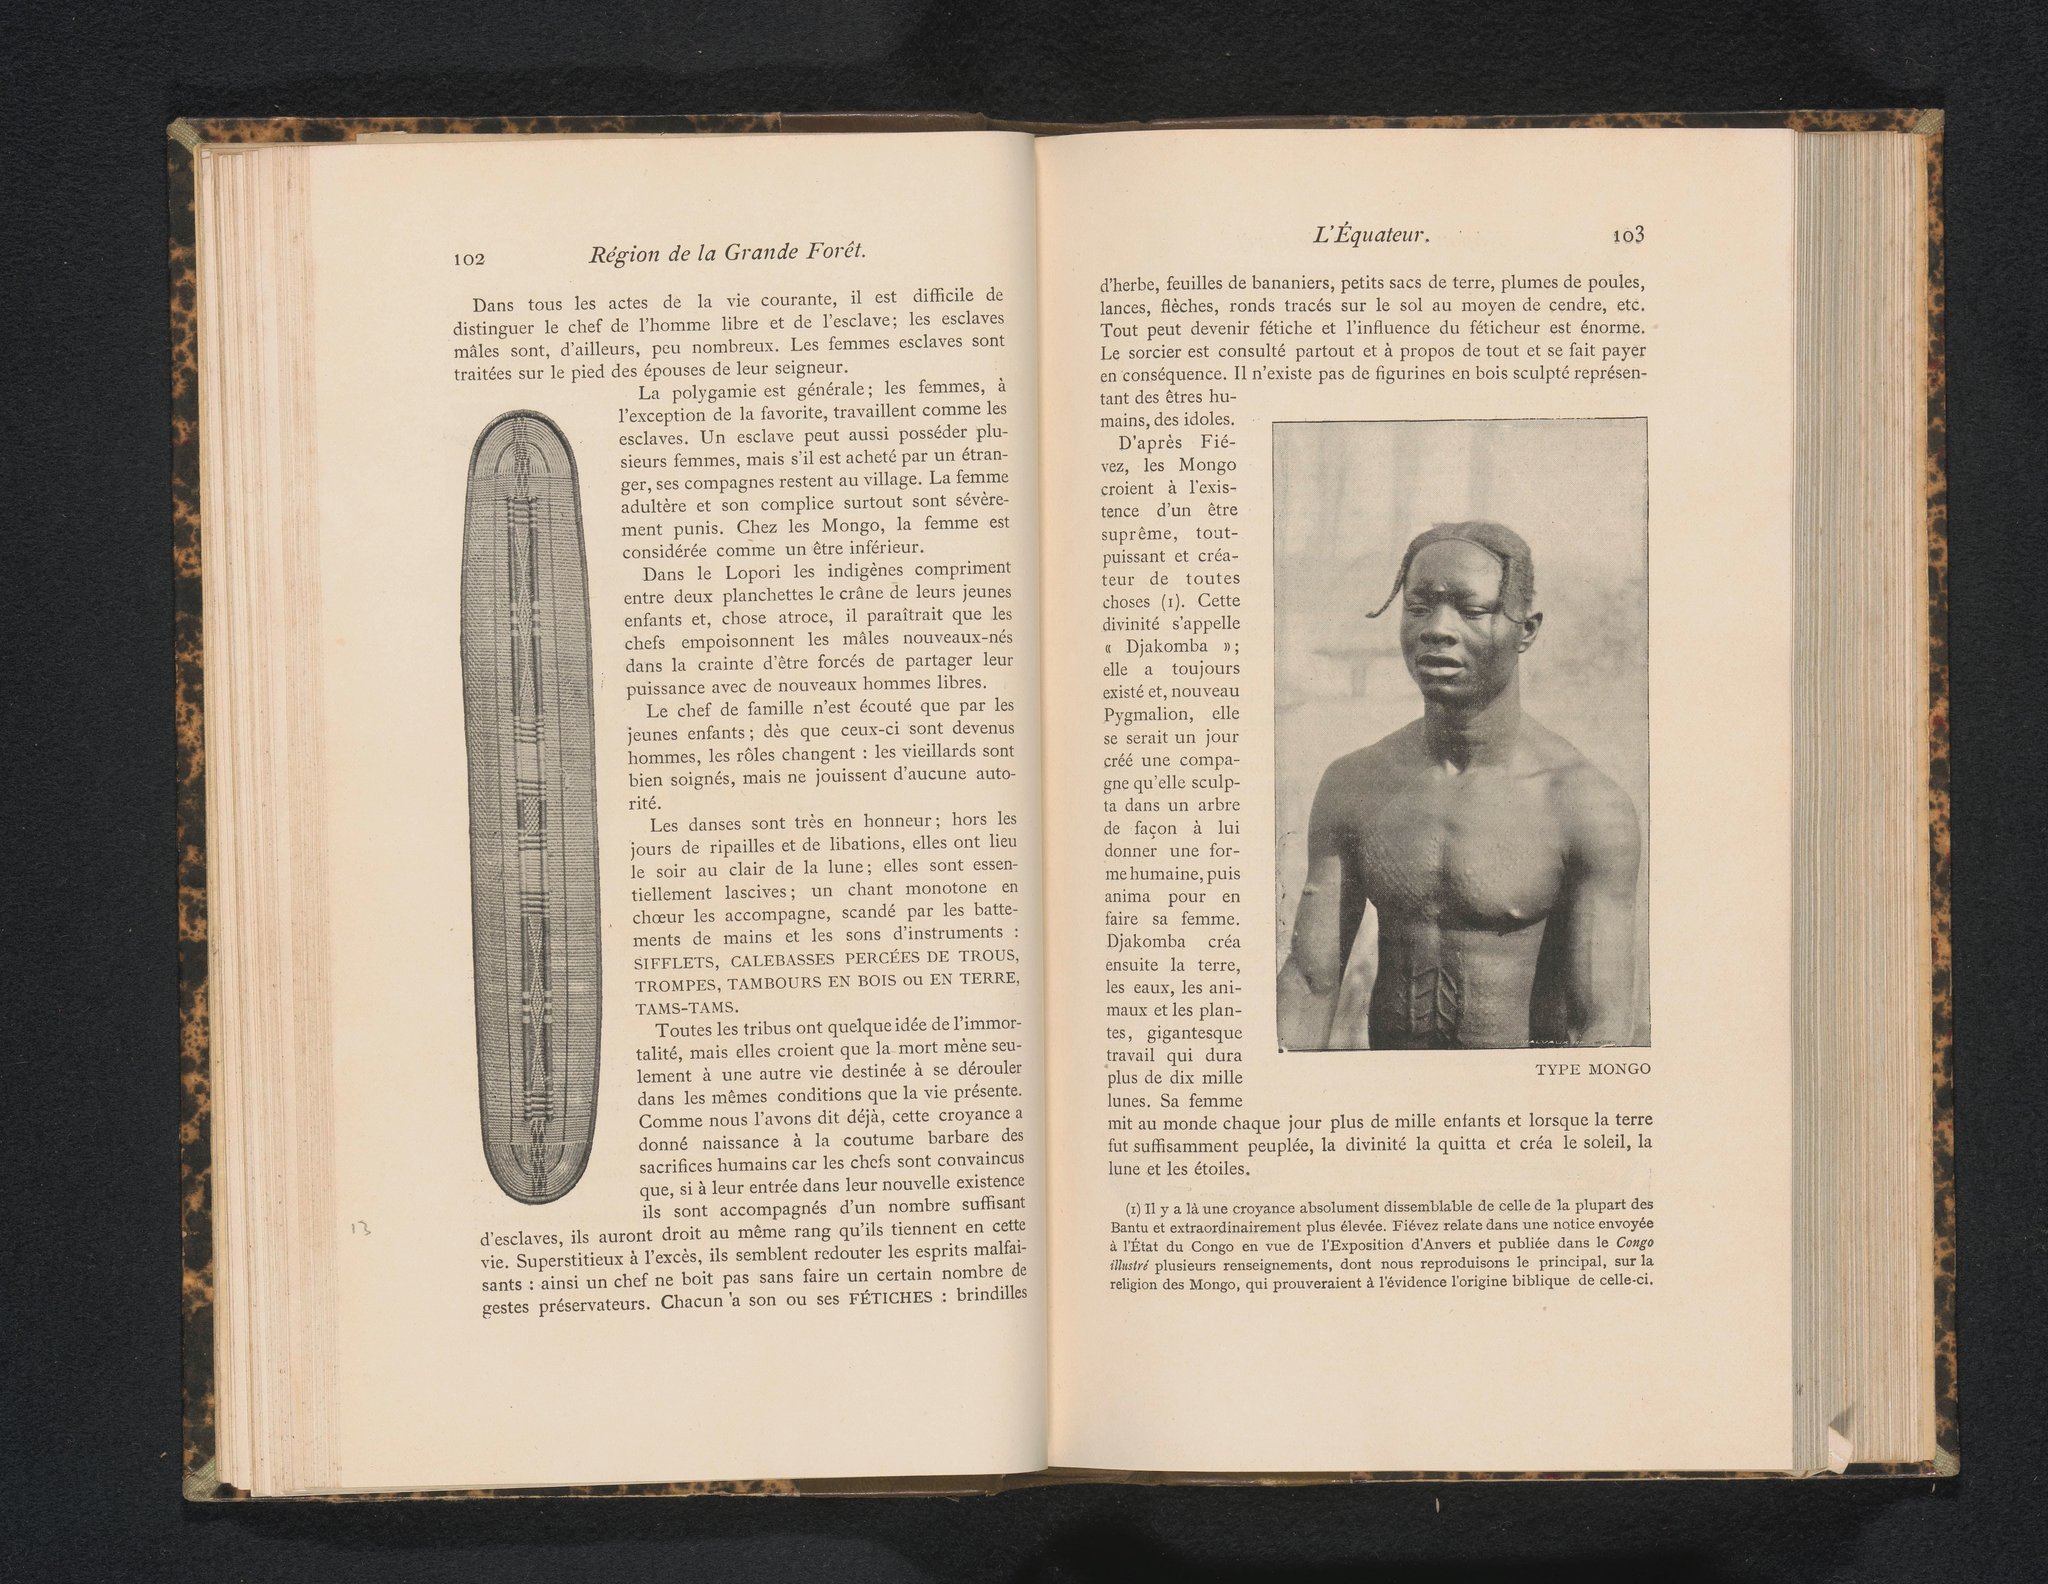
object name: page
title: Gevlochten schild van een Mongo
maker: Anonymous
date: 1892-1897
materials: paper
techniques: autotype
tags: protective weapons: shield